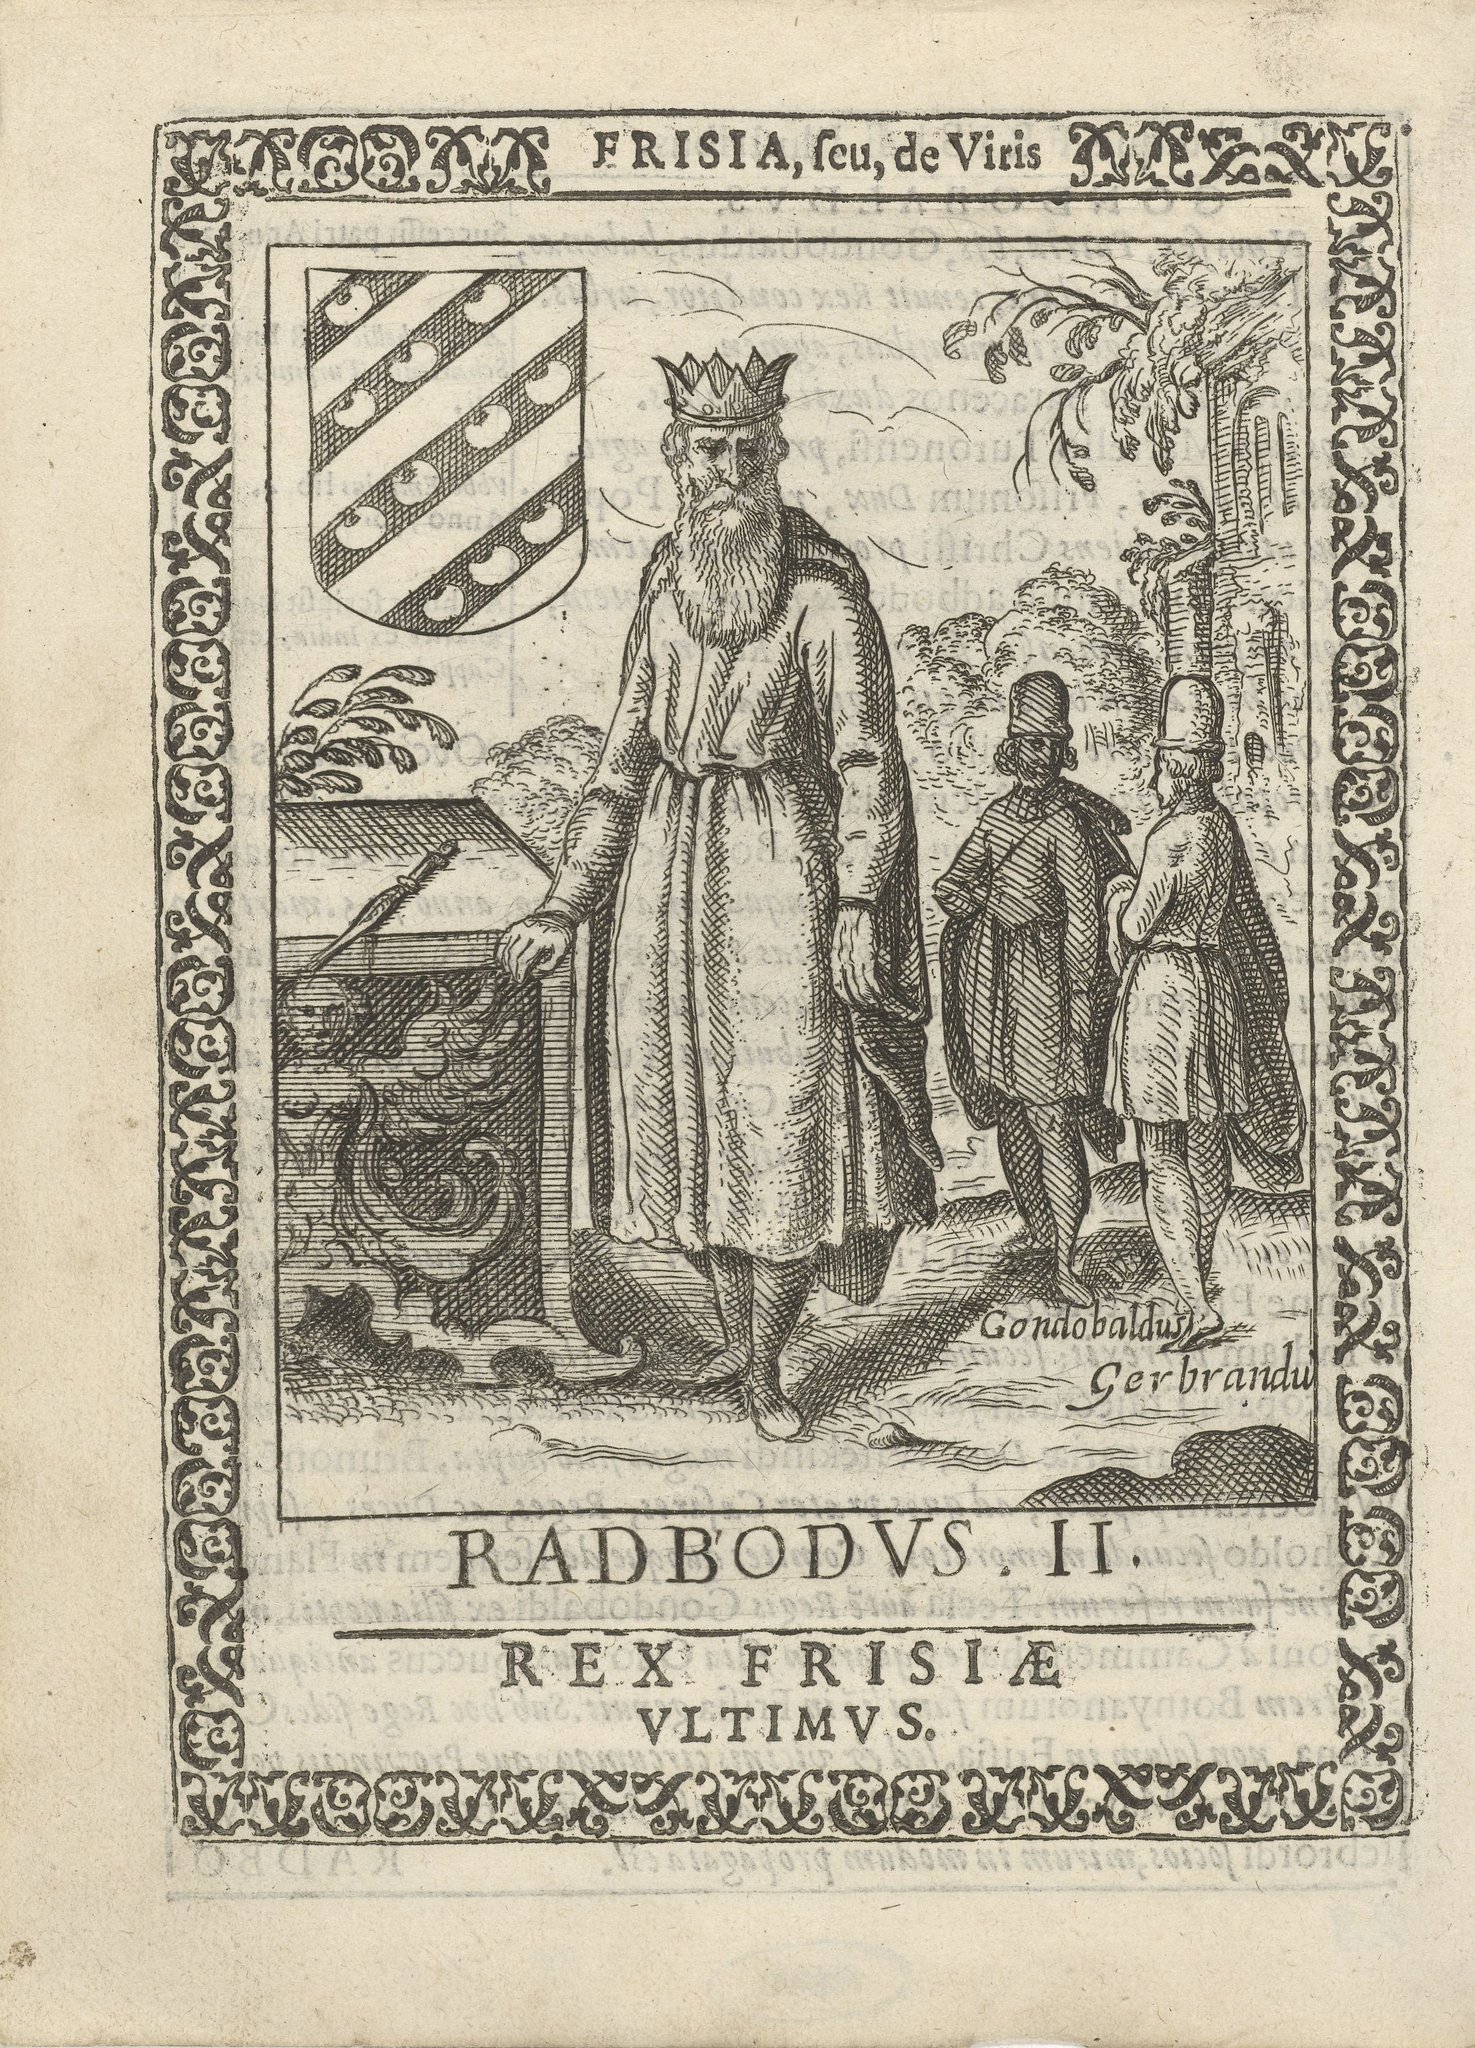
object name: print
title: Koningen en Potestaten van Friesland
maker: pieter feddes van harlingen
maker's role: painter, print maker, publisher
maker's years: 1586-1623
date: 1618-1620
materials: paper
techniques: etching, letterpress printing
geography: friesland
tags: ruler, sovereign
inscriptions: collector's mark: Lugt 2228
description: Radbod II, laatste koning der Friezen. Staande ten voeten uit. Op de achtergrond Gondobaldus en Gerbrandus. In een ornamentale omlijsting. Illustratie, met tekst op achterzijde, afkomstig uit het boek: Frisia seu de viris rebusque Frisiae illustribus libri duo.